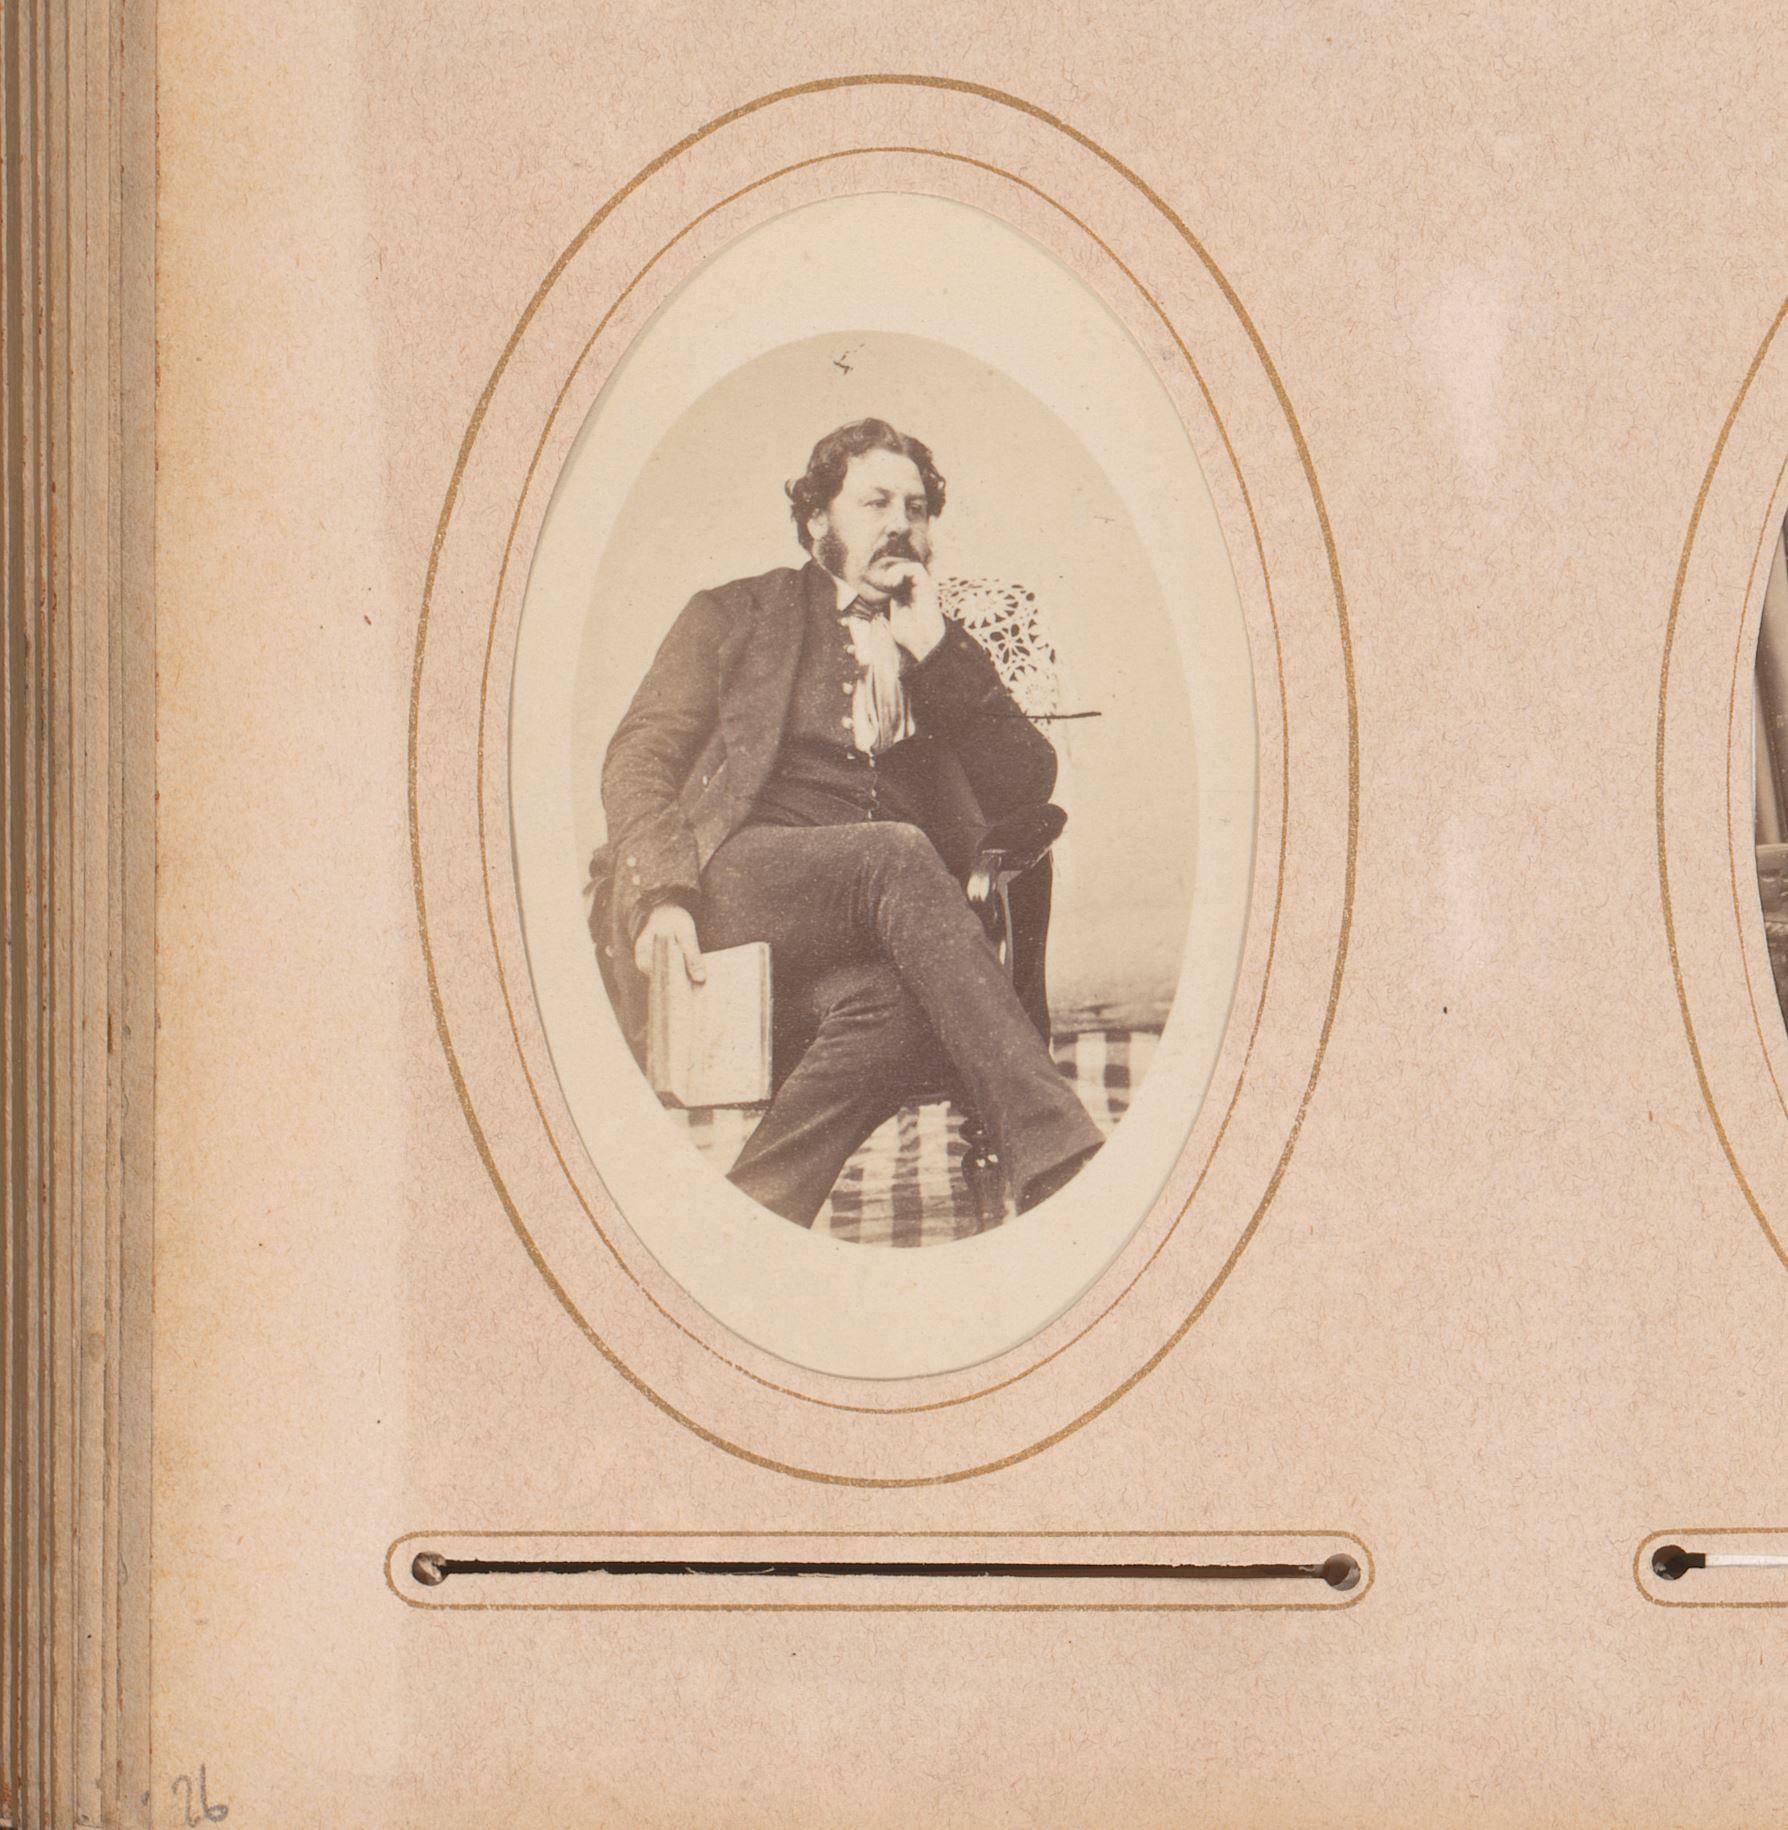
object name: carte de visite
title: Portret van een zittende man met boek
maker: walter clayton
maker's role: fotograaf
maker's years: 1833-1893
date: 1860-1890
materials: cardboard, photographic support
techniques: albumen print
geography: nottingham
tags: sitting figure, historical persons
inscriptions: inscription: ‘W. Clayton/ Artist & Photographer/ Grey Hound Street/ Long Row/ facing exchange corner/ Nottingham’